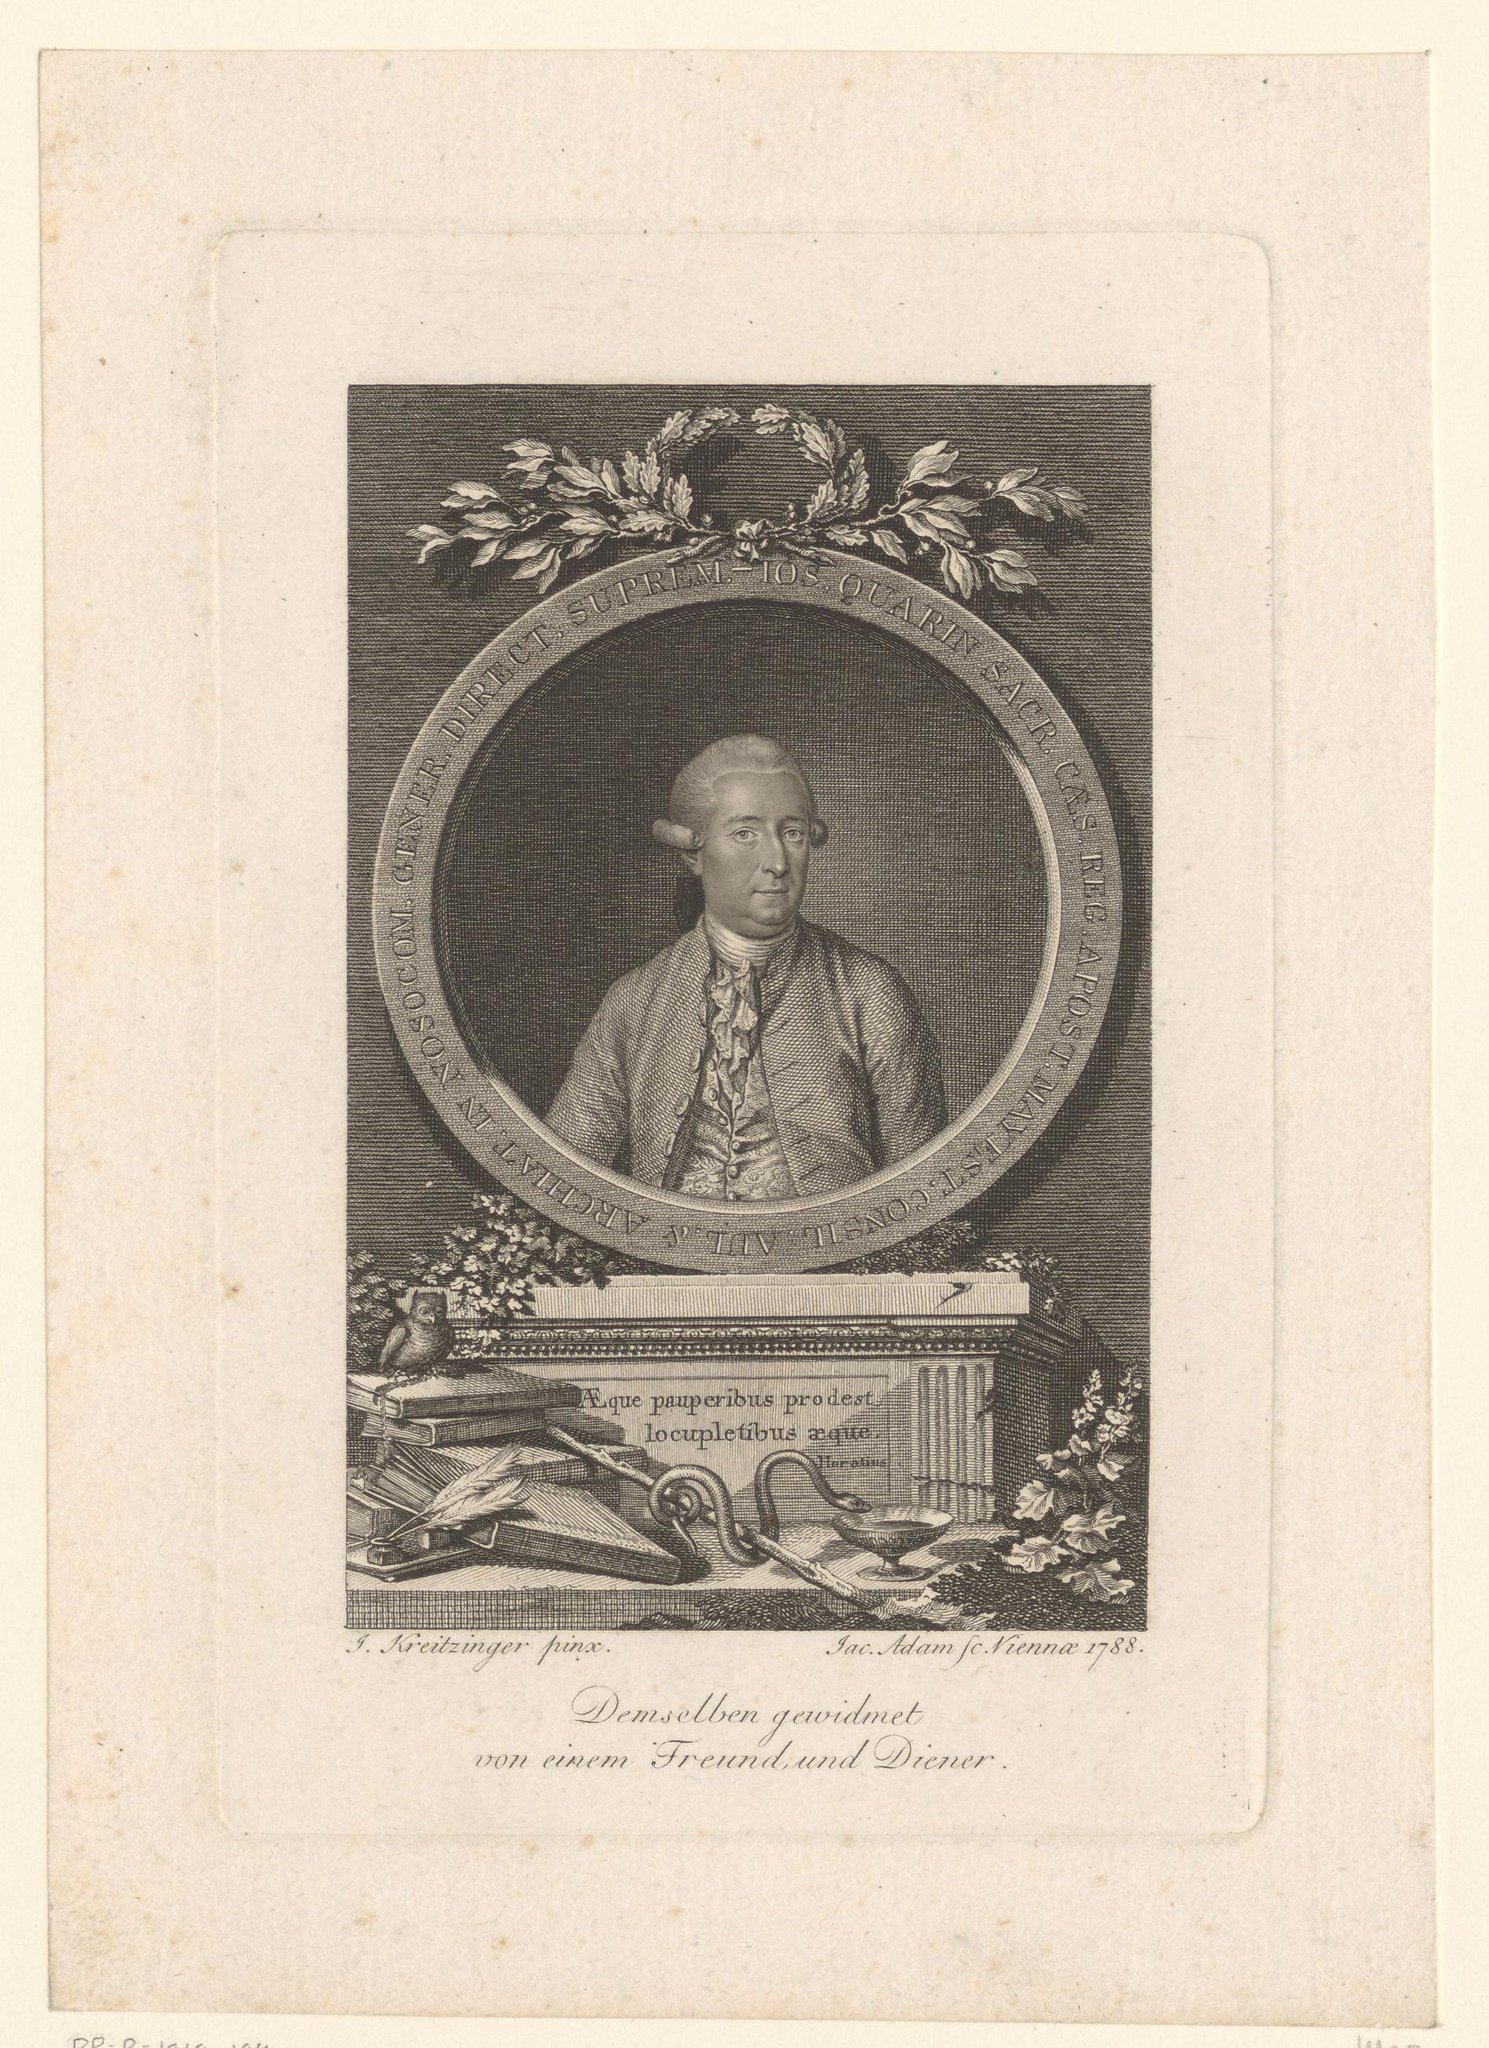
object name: print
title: Portret van Joseph von Quarin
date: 1758-1811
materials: paper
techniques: etching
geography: vienna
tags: vienna, joseph freiherr von quarin, attributes of aesculapius: rod and serpent, historical persons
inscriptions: collector's mark: Lugt 2228